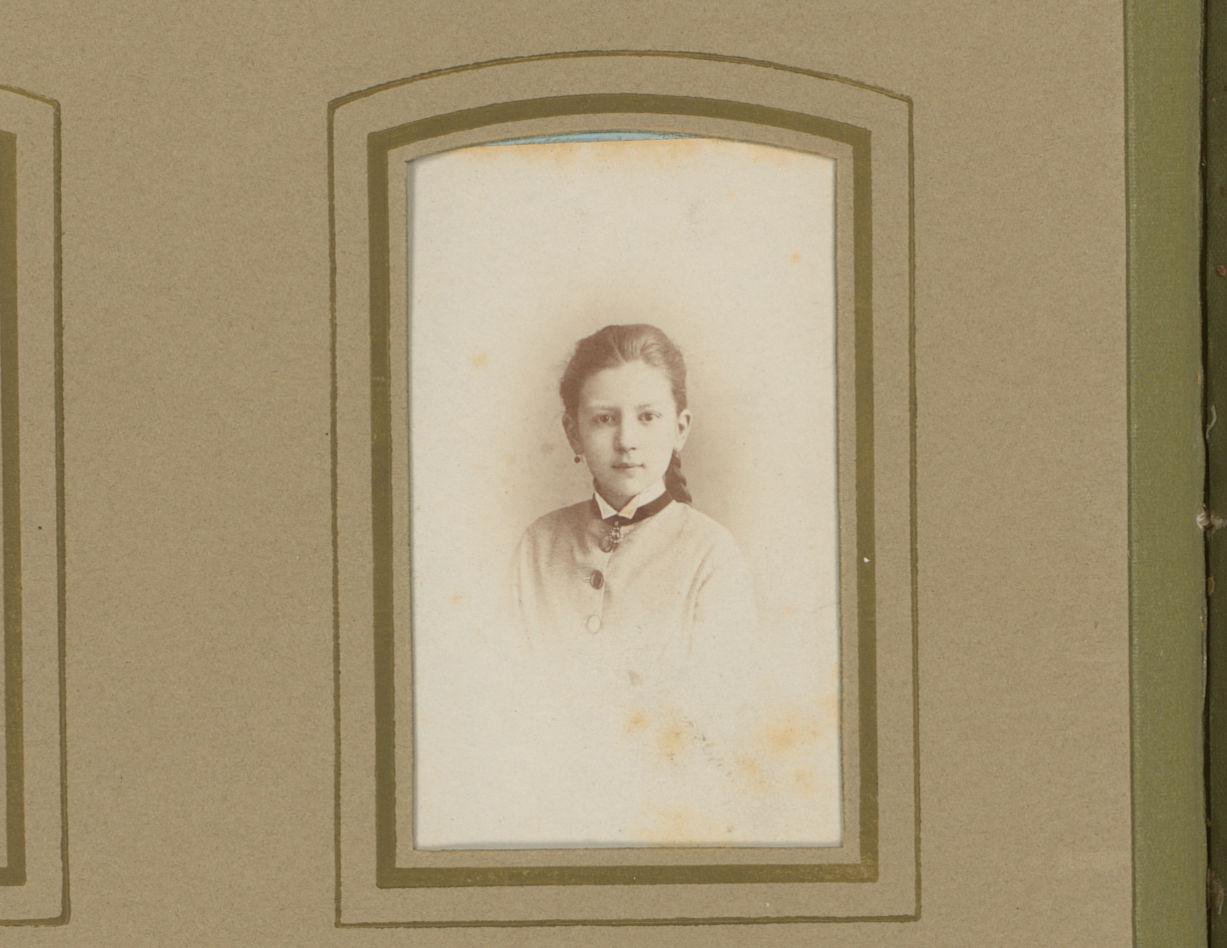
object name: album leaf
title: Portret van een meisje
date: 1875-1900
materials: cardboard, photographic support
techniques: albumen print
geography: amsterdam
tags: historical persons - bb - woman, girl (child between toddler and youth)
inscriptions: inscription: ‘Wegner & Mottu/ Photographisch Artistisch Atelier/ AMSTERDAM/ Rokin . D 88.’